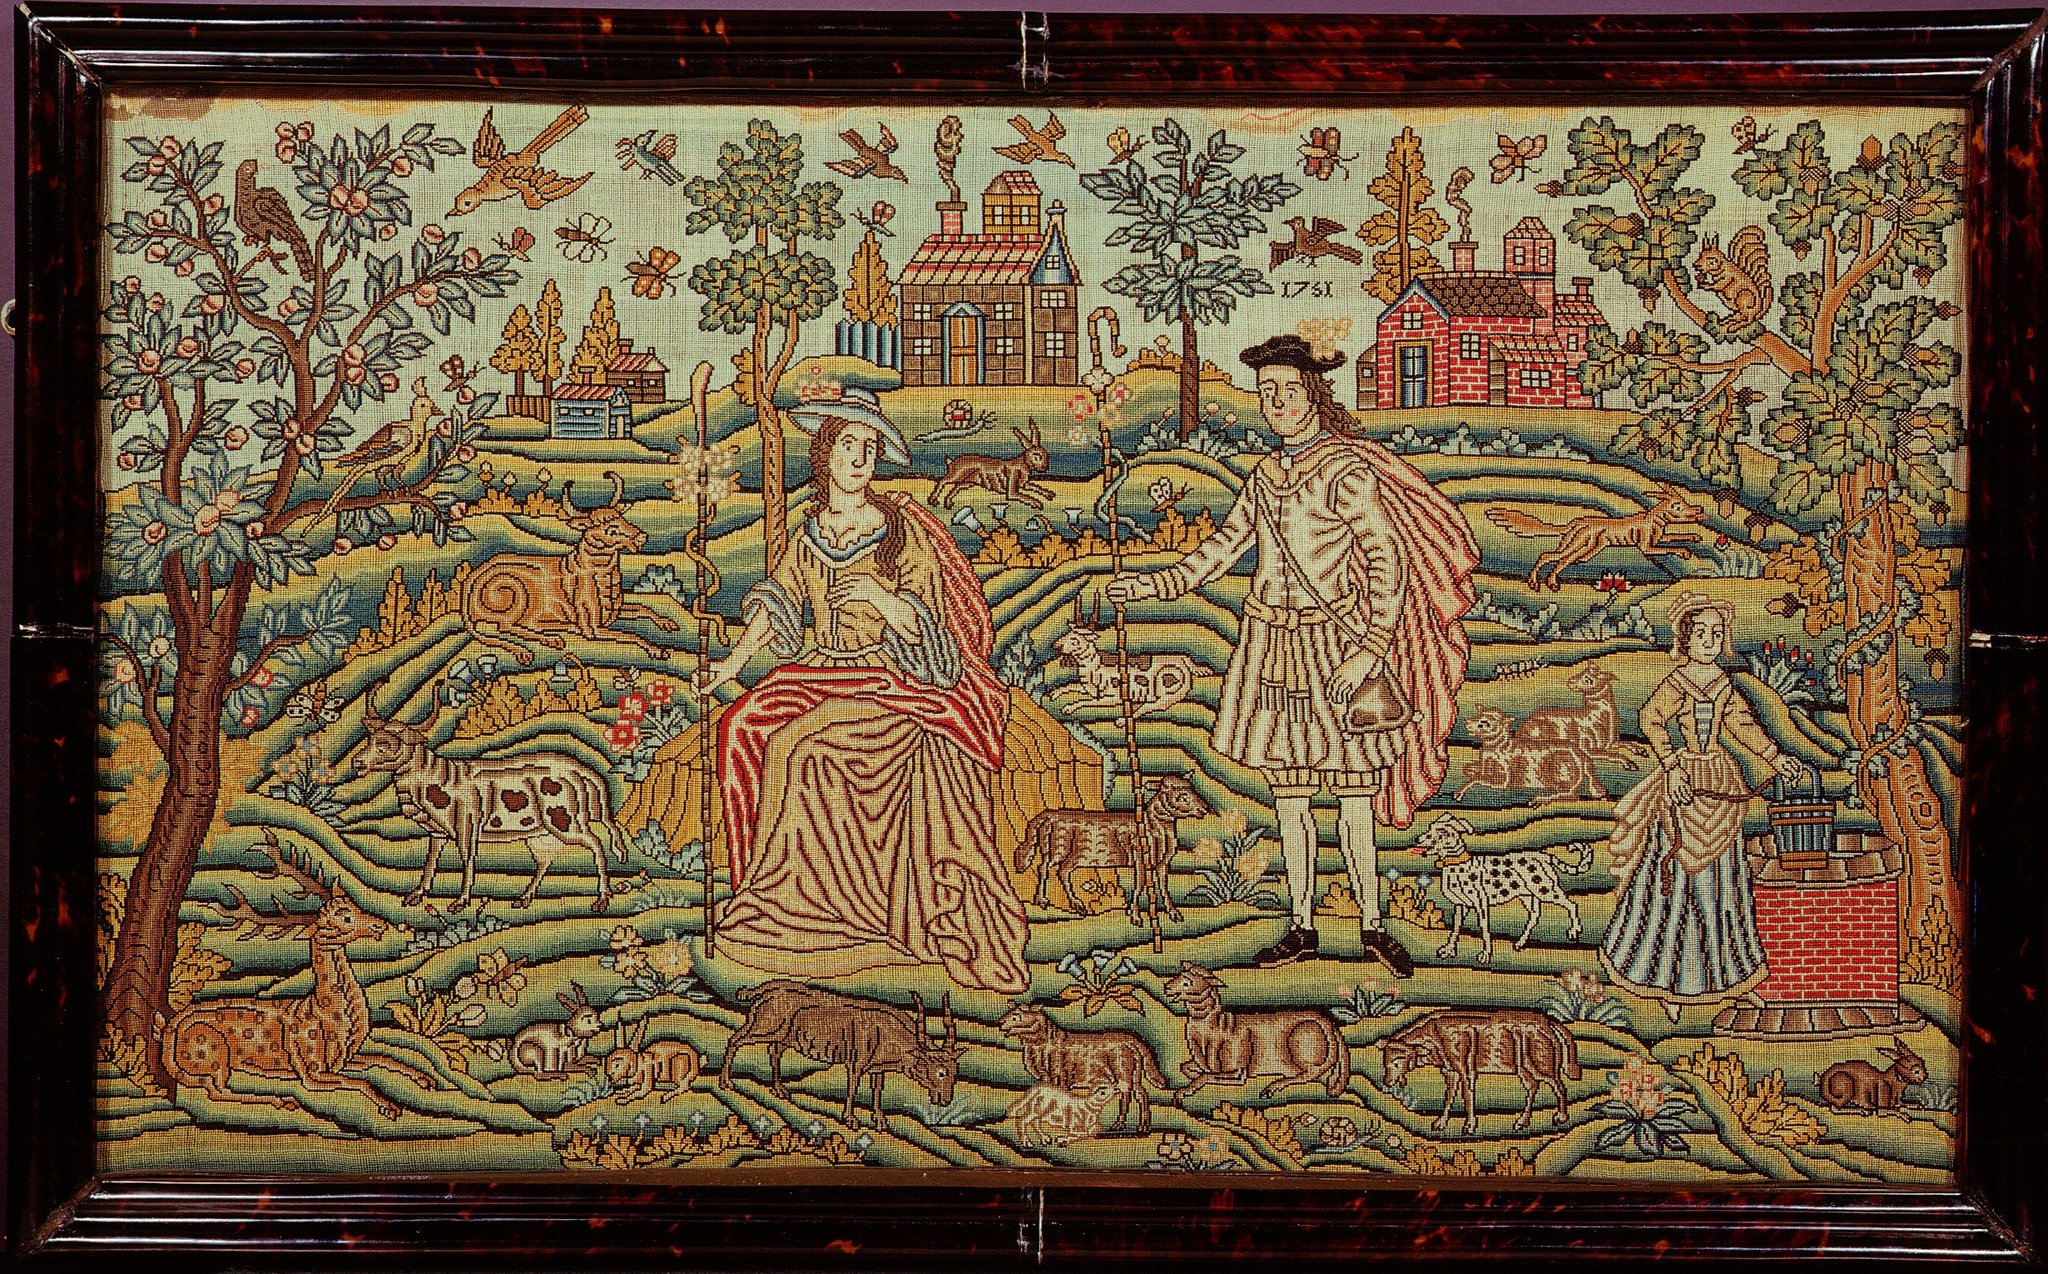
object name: embroidered picture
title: Embroidered picture with pastoral scene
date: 1761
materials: canvas, silk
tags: birds,houses,men,women,cows,deer,dogs,insects